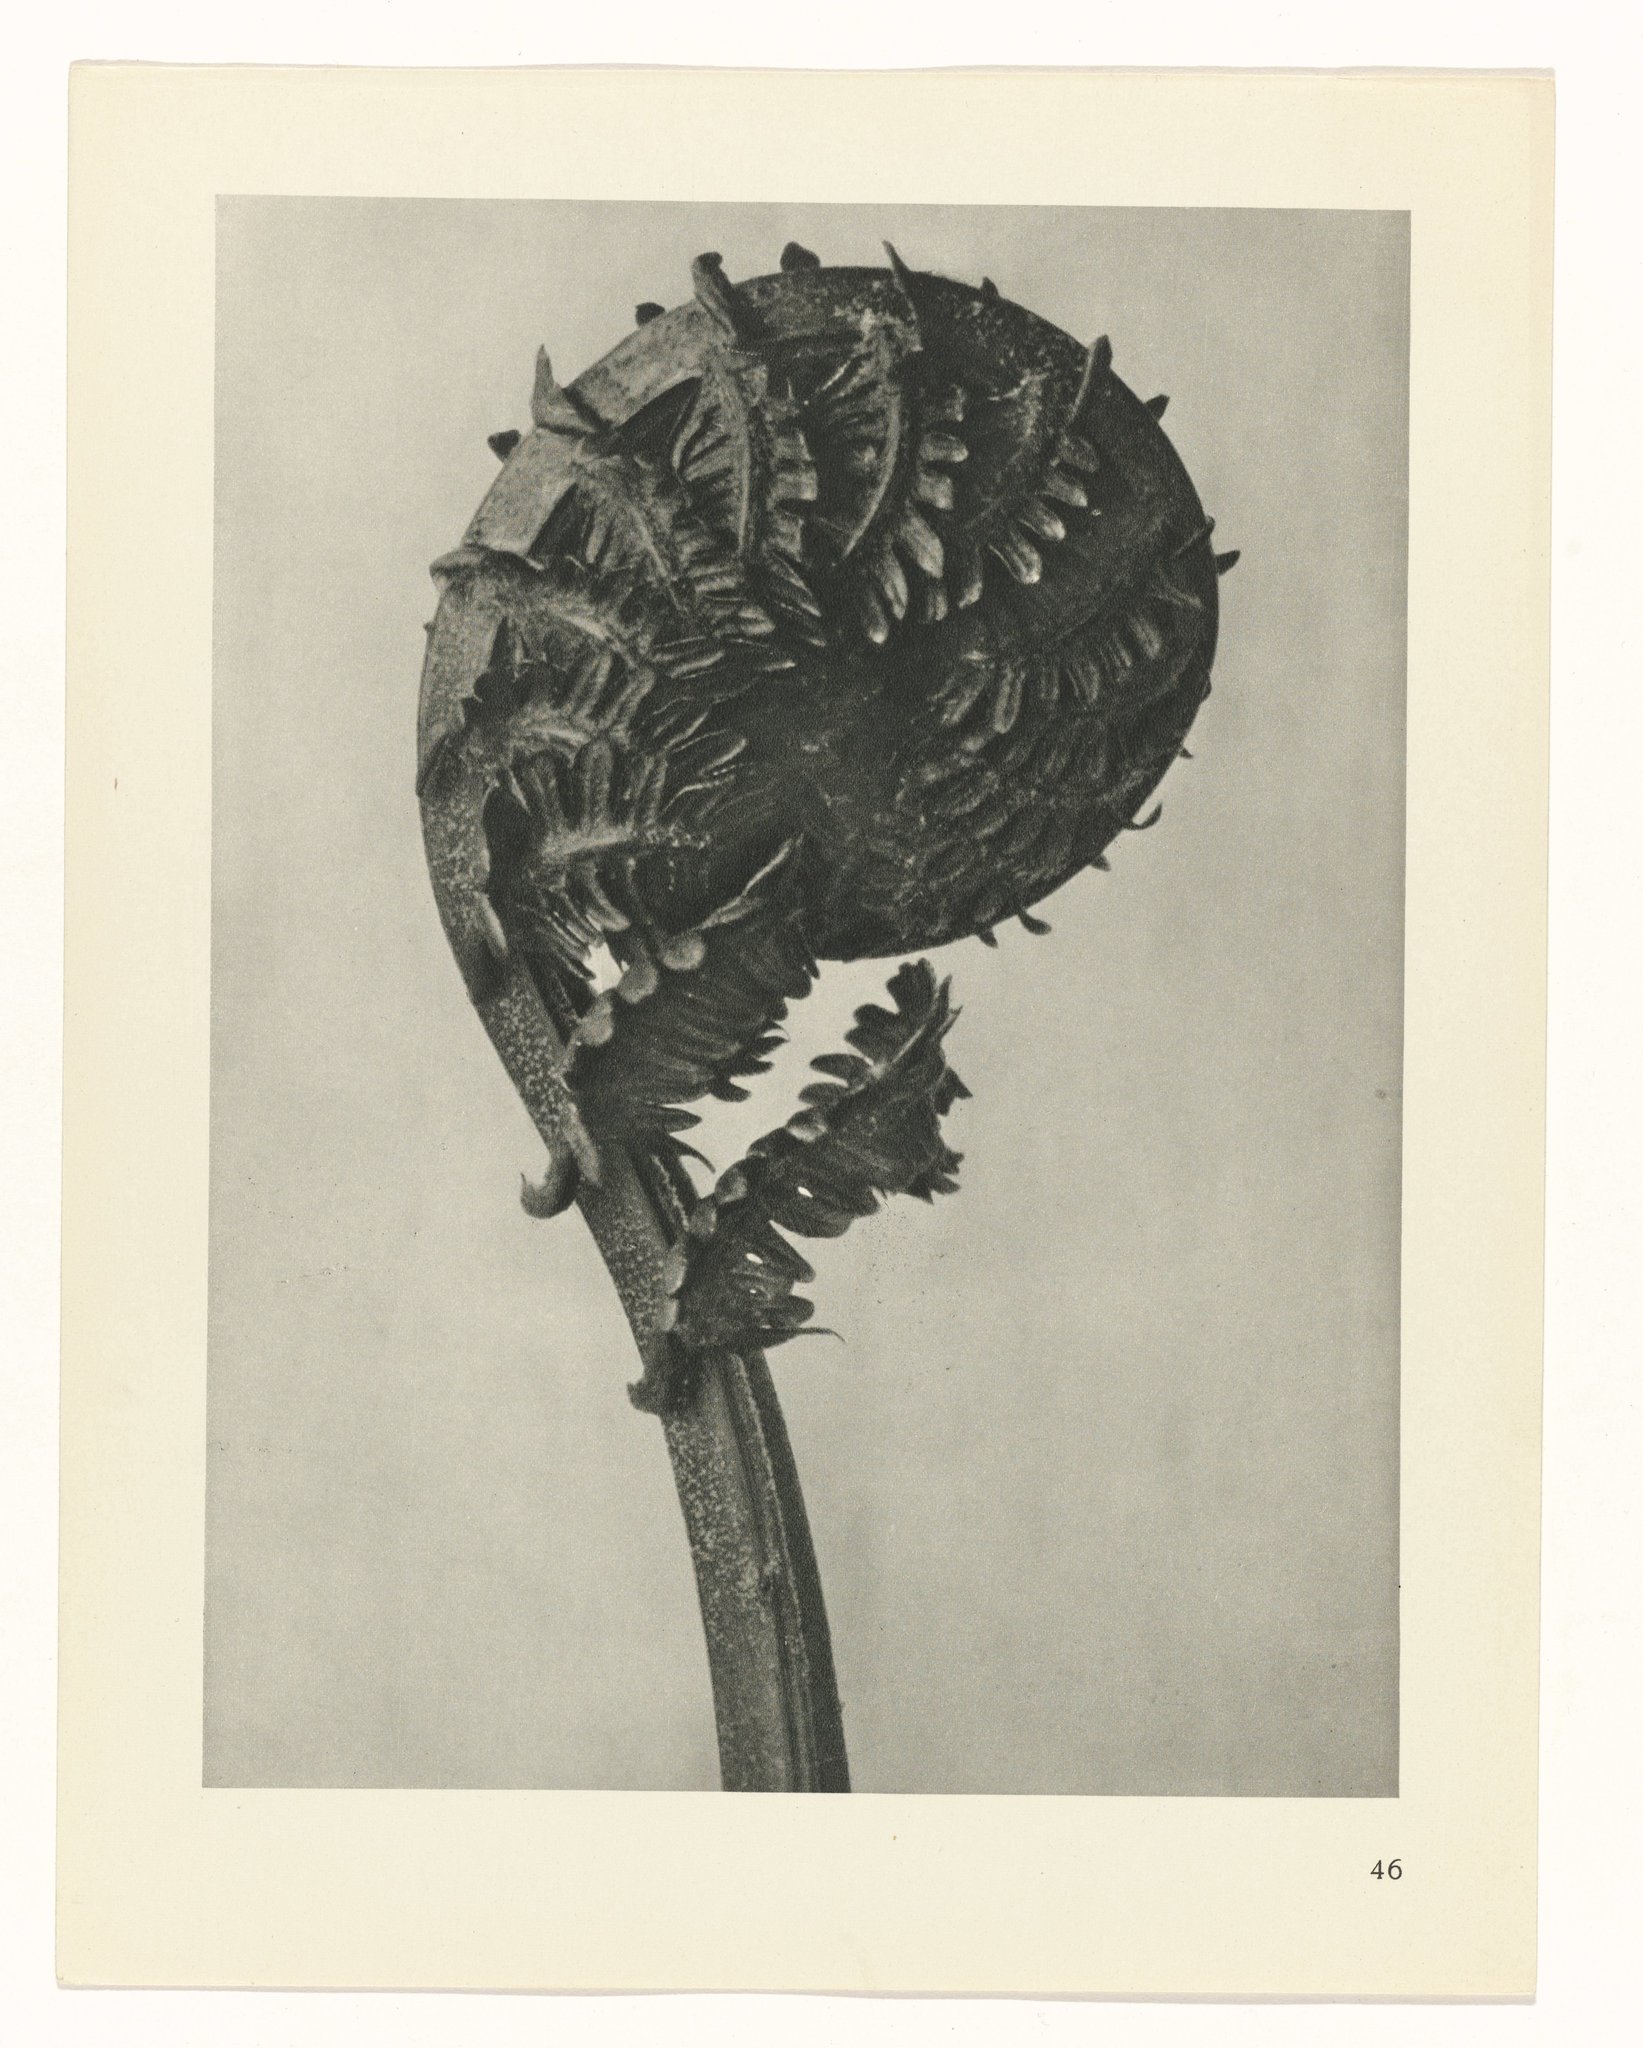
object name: photograph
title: Urformen der Kunst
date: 1928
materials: ink, paper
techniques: rotogravure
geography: berlin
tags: plants (in general)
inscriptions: number: ‘46’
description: facher Vergrößerung. Afkomstig uit losbladige uitgave.